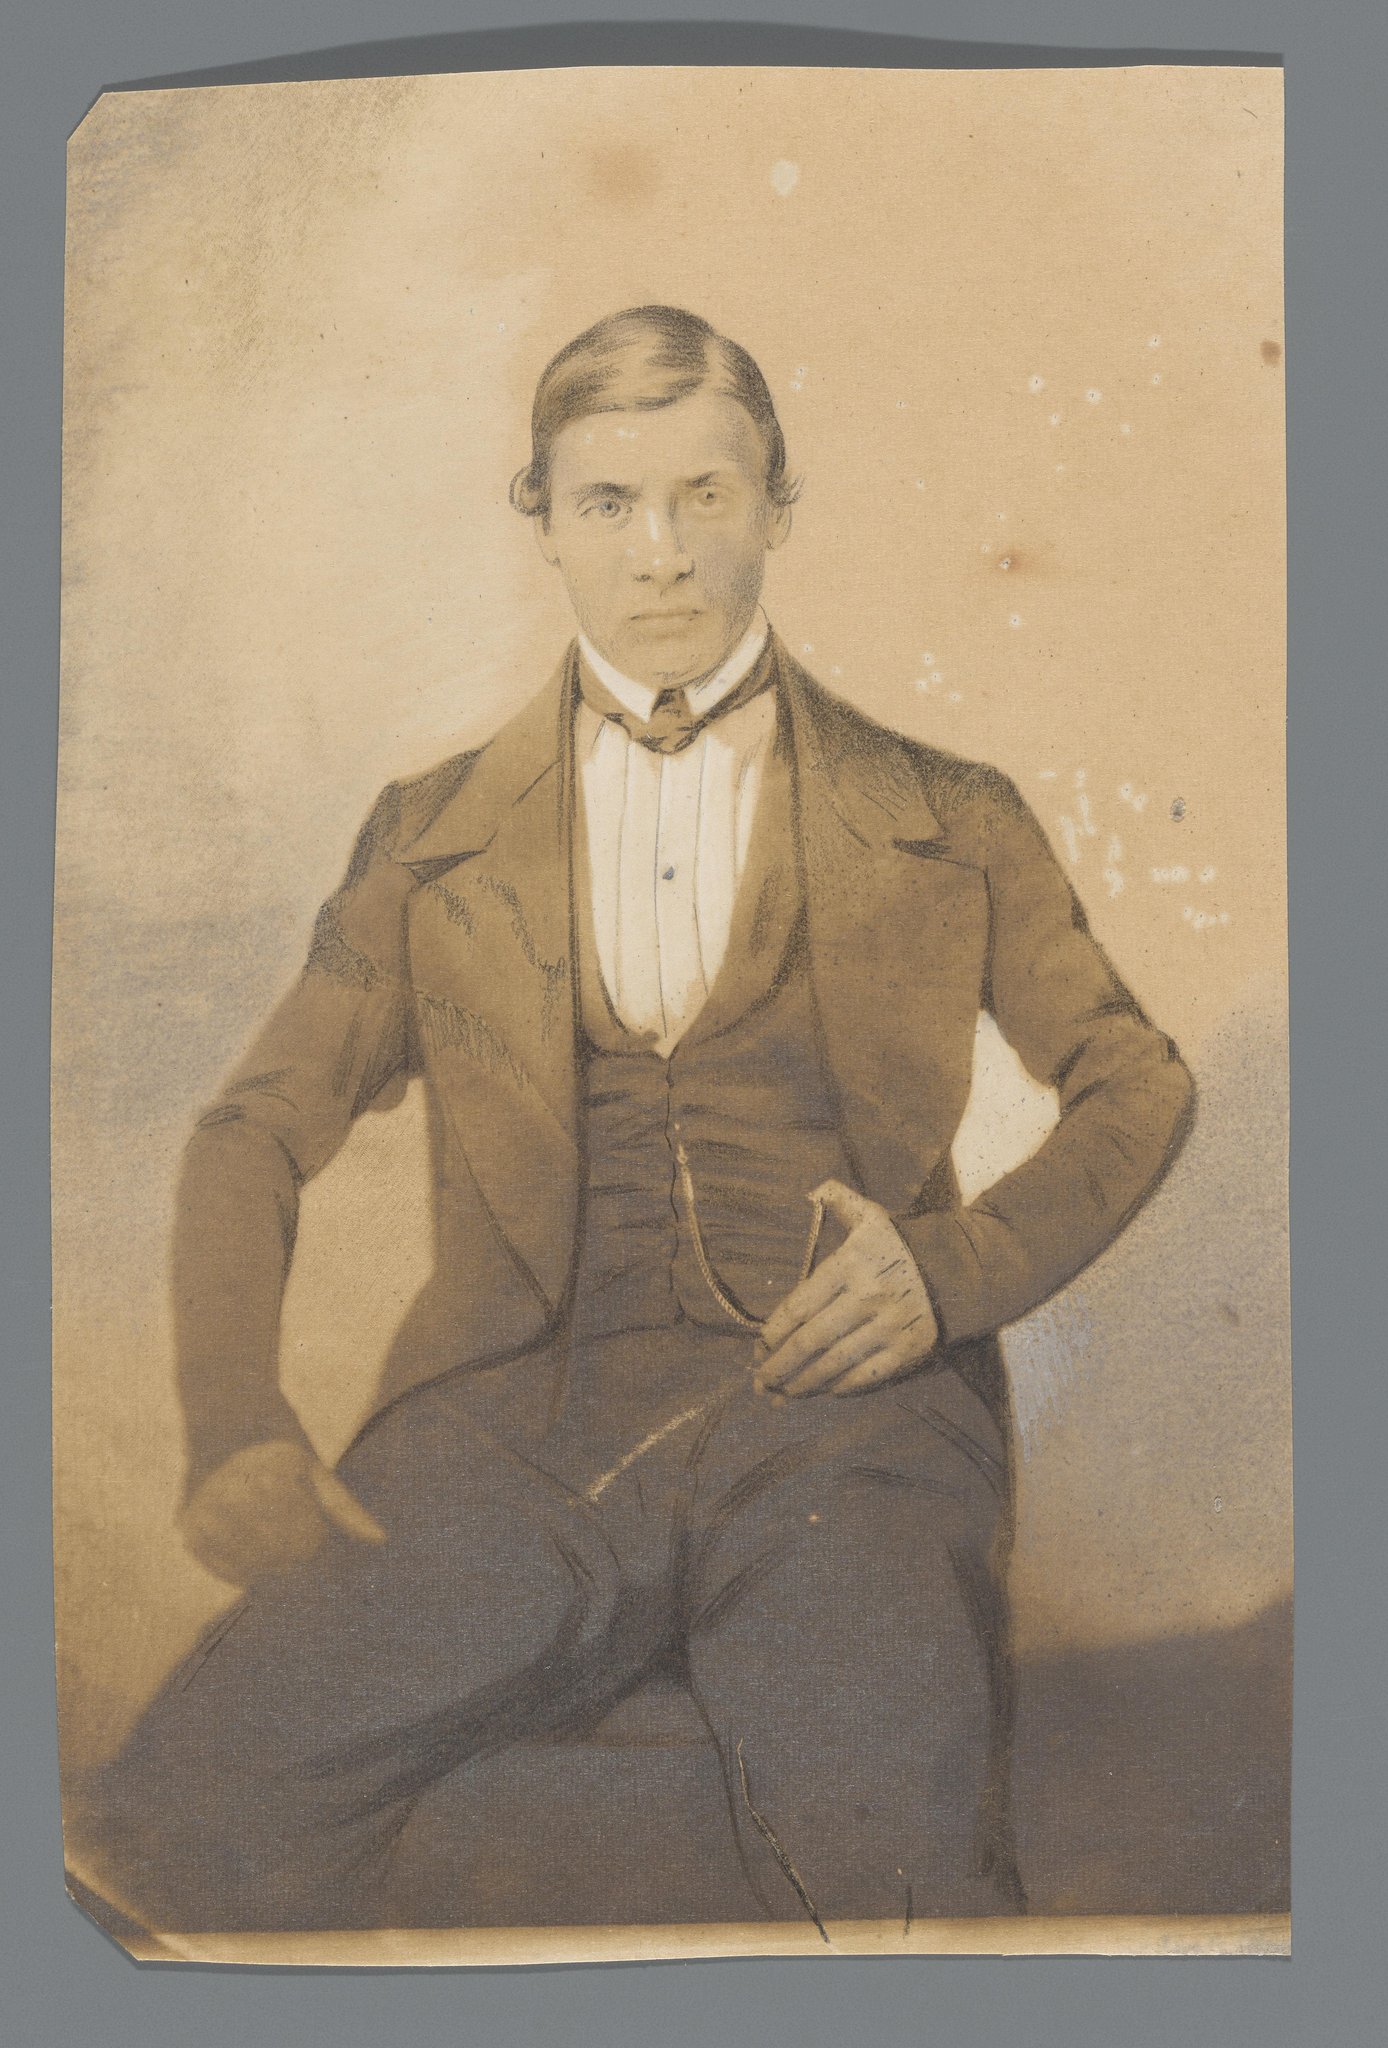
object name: photograph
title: Portret van een man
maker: Anonymous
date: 1850-1920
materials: photographic support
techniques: salted paper print